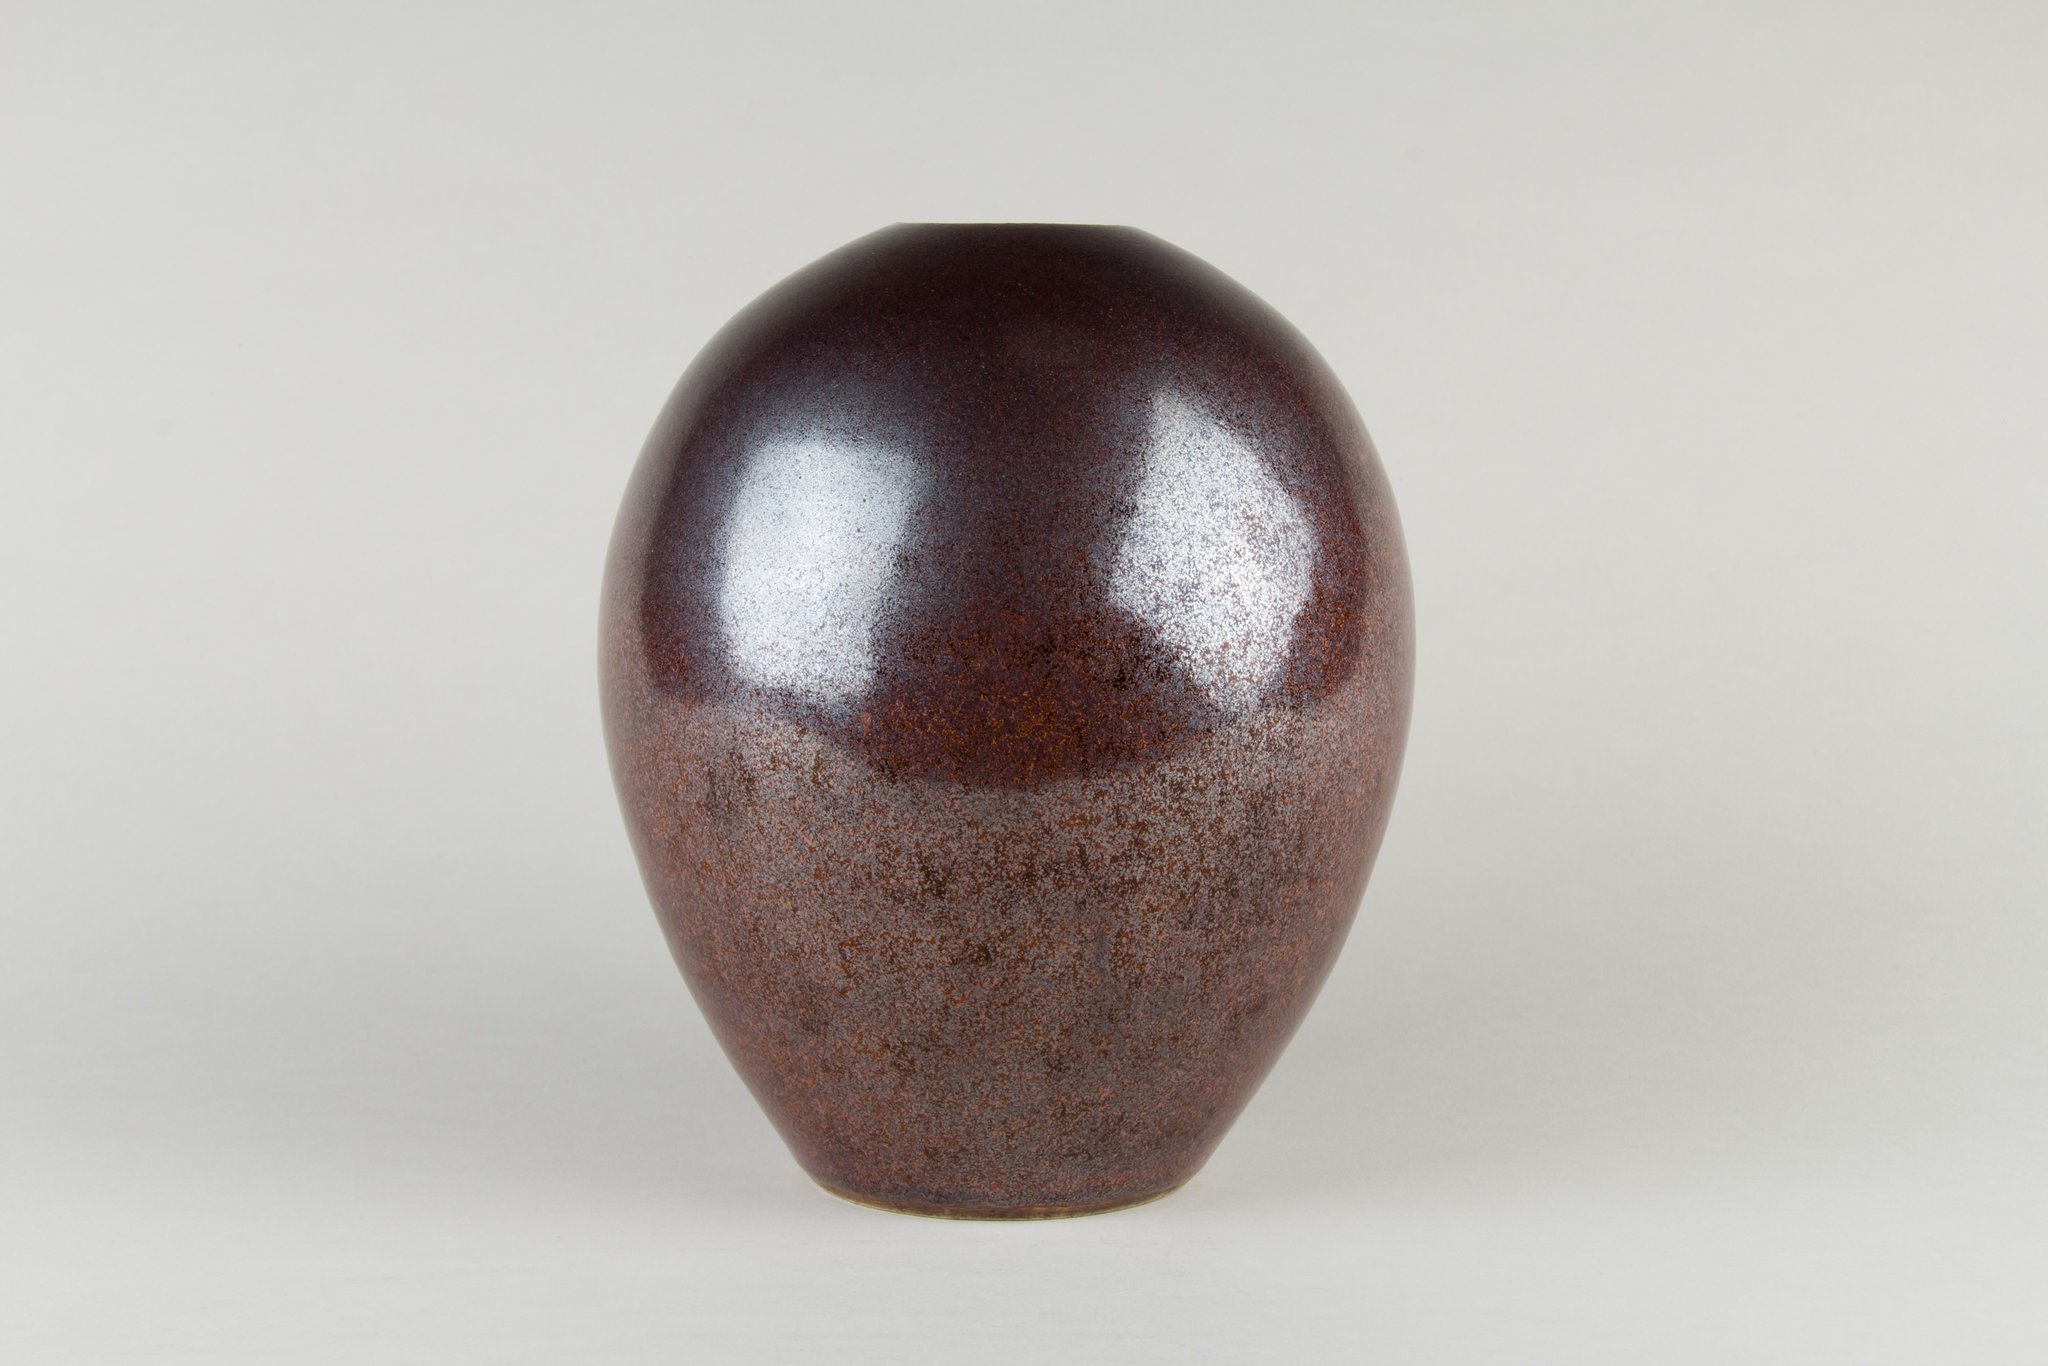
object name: jar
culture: chinese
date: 1701-1800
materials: glaze, iron, porcelain